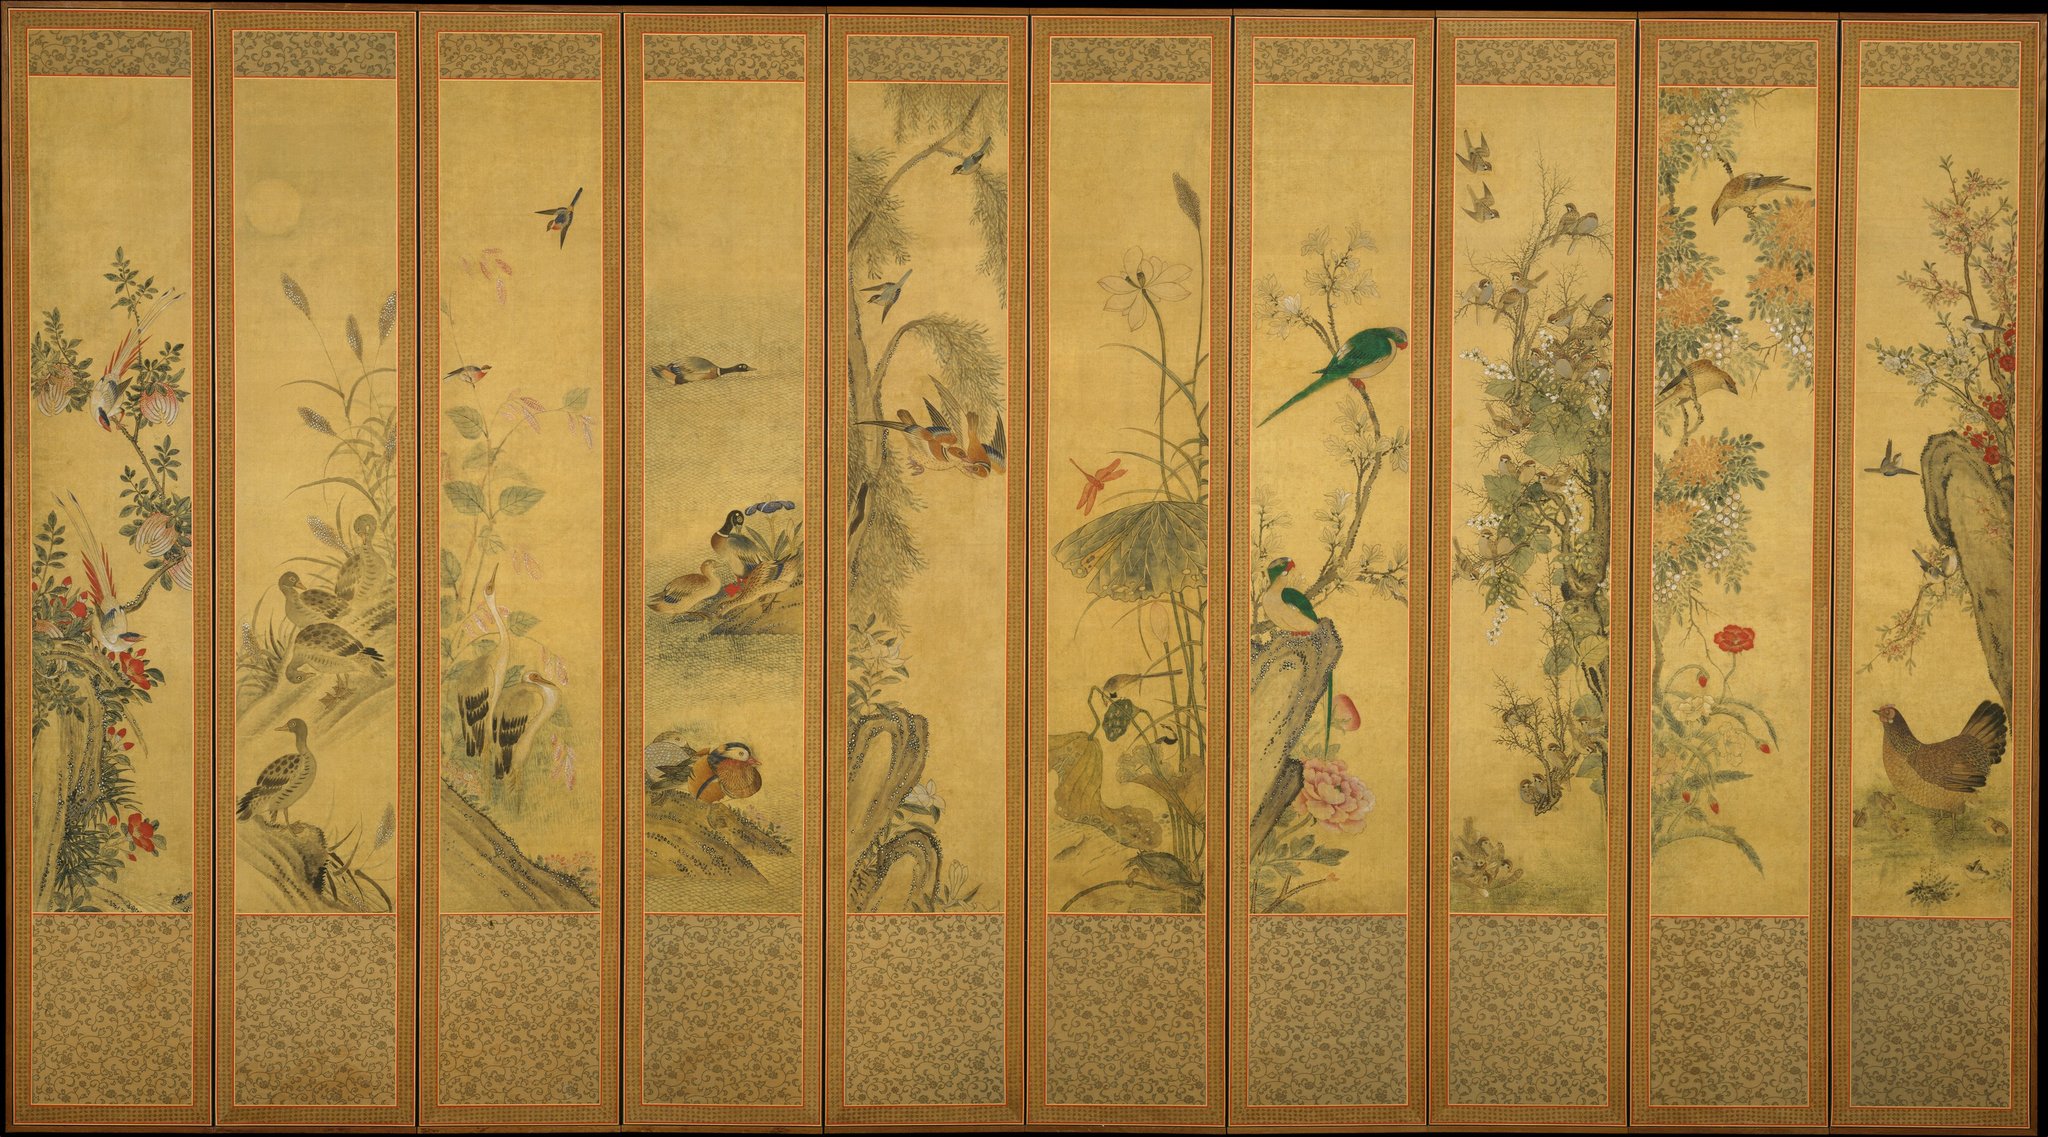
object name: screen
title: Birds and Flowers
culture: korean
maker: unidentified artist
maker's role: artist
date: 1867-1933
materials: ink, panel, silk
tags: birds,flowers,plants